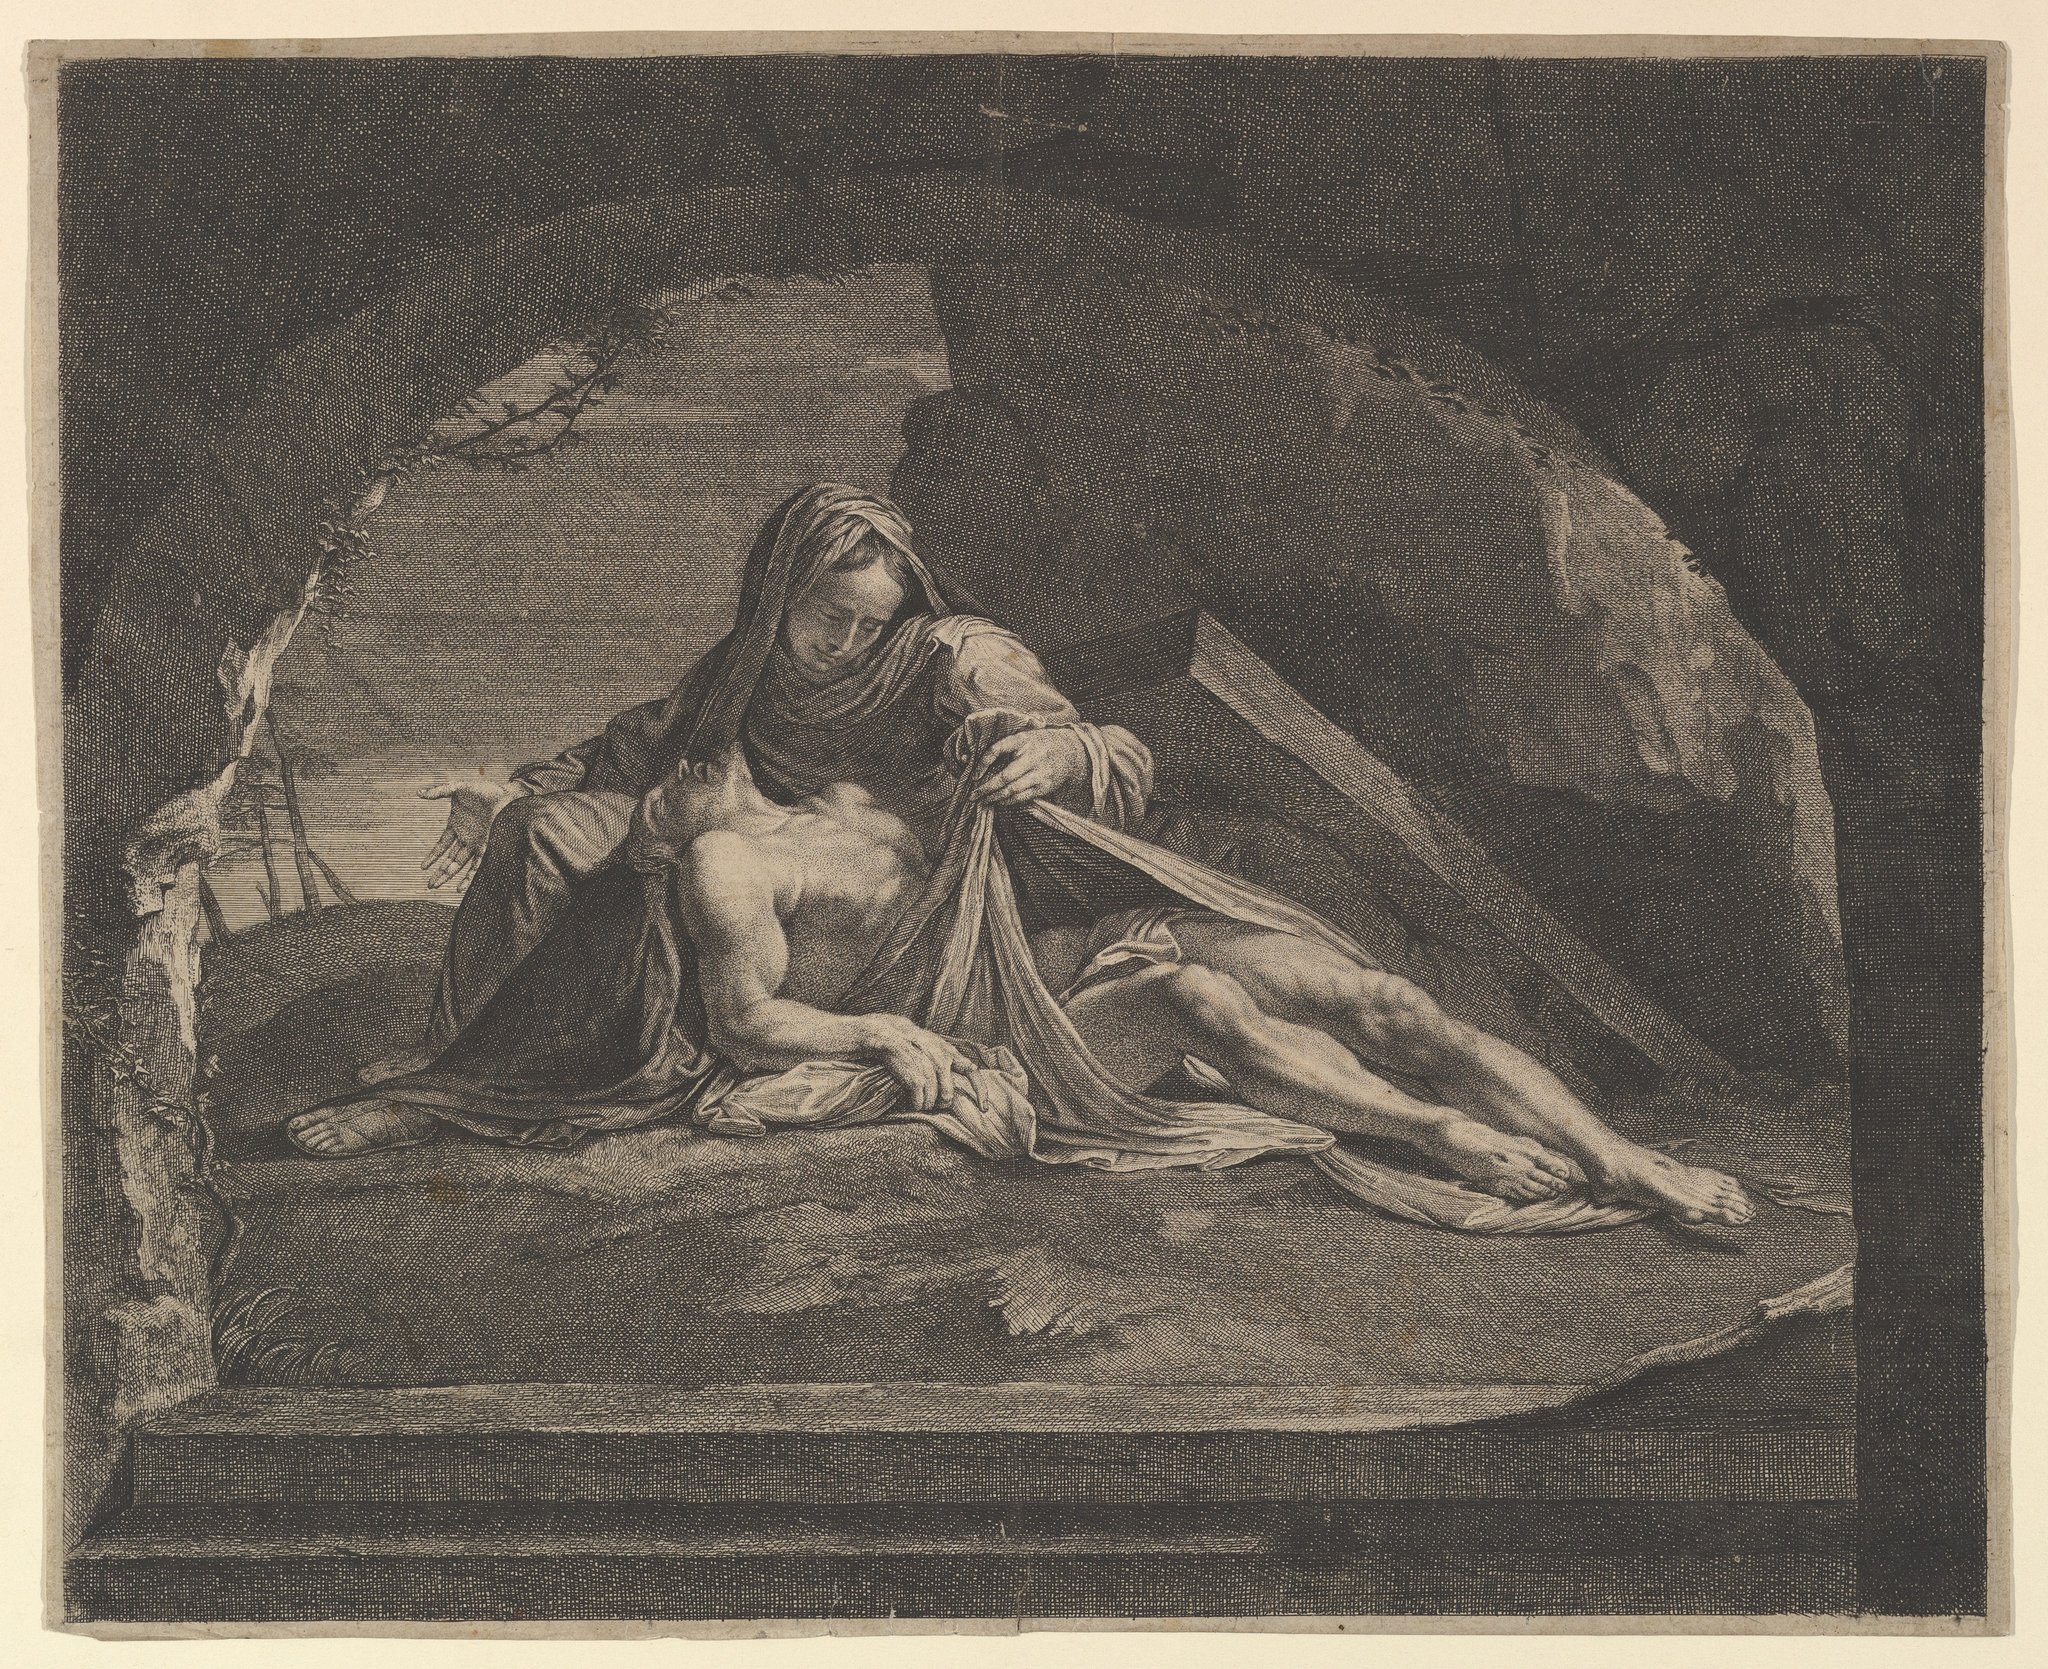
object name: print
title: La Vierge au sepulcre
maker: jean morin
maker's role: artist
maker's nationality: french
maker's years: 1605-1650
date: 1605-1650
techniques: etching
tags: virgin mary